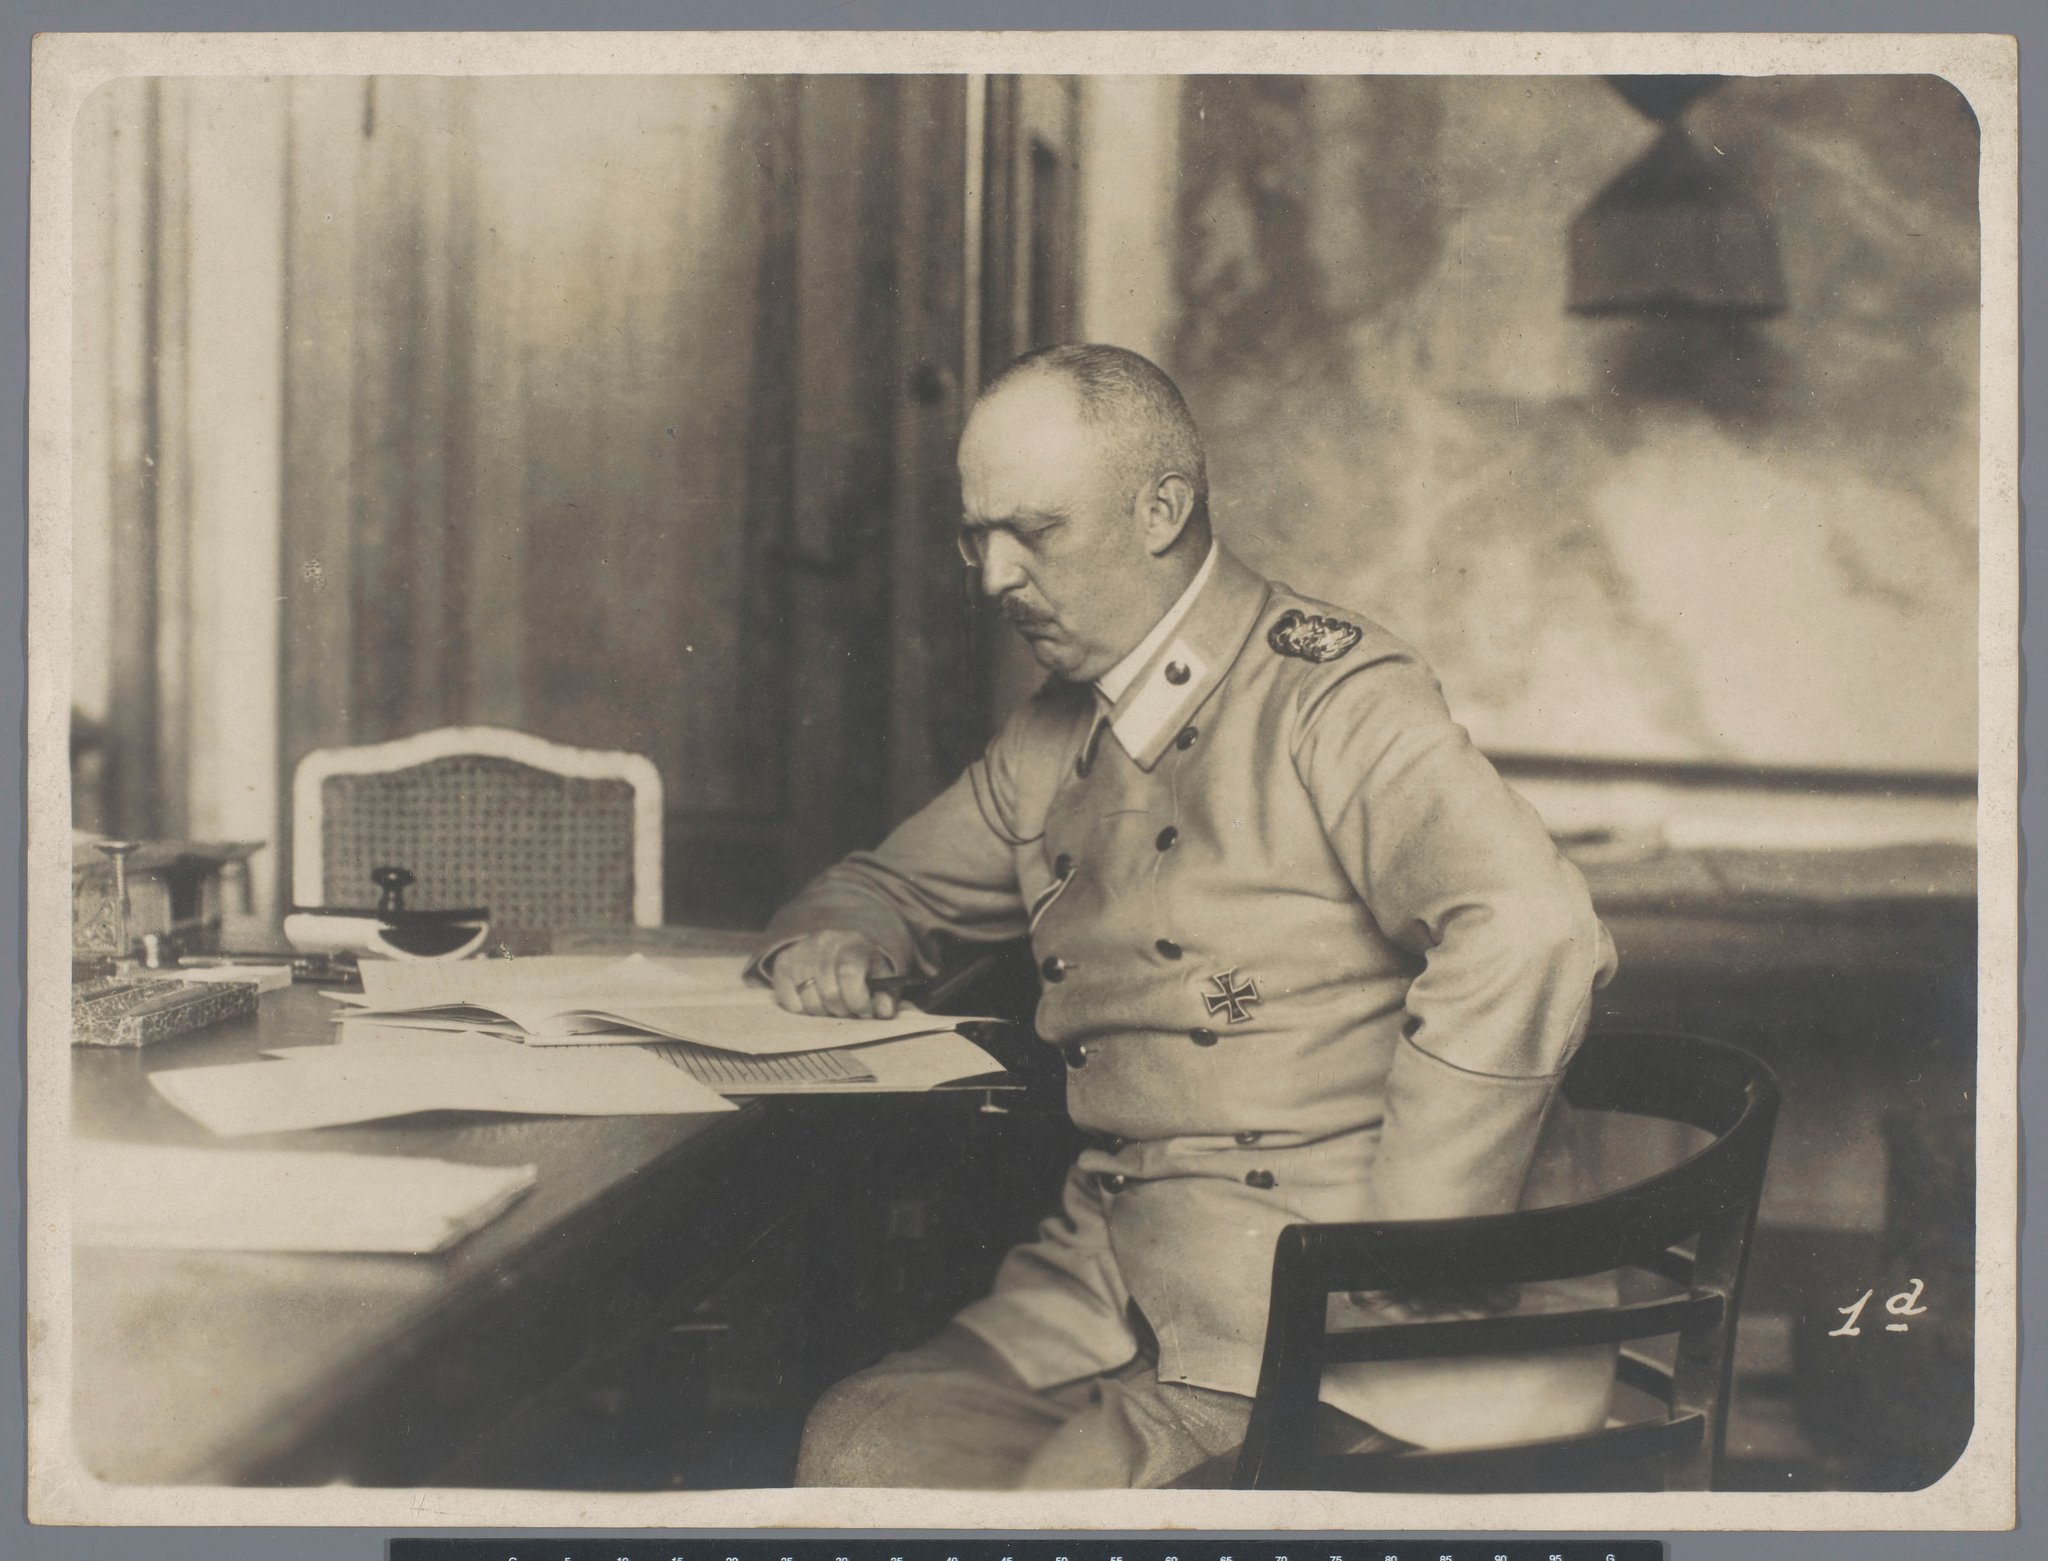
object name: photograph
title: Portret van de Duitse generaal-kwartiermeester Erich Ludendorff in zijn werkkamer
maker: Anonymous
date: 1918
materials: paper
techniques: gelatin silver print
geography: germany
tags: commander-in-chief, general, marshal, historical persons, germany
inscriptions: inscription: ‘1a. De Duitsche Generaal-kwartiermeester Ludendorff.’, inscription: ‘Erich Ludendorff 1865-1937’, number: ‘1a’